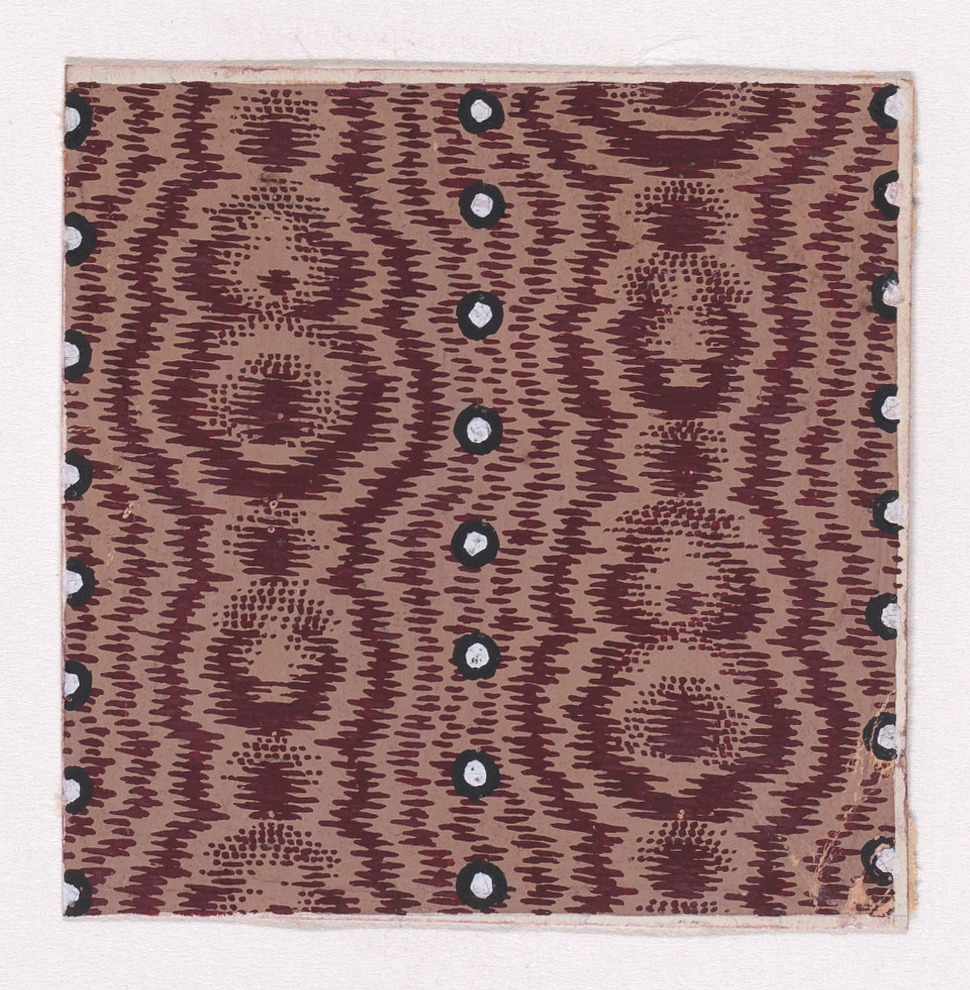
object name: drawing ornament architecture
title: Textile Design with Alternating Vertical Stripes of Abstract Figures and Pearls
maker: anonymous, alsatian, 19th century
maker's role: artist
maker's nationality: alsatian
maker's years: 1800-1900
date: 1840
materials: gouache